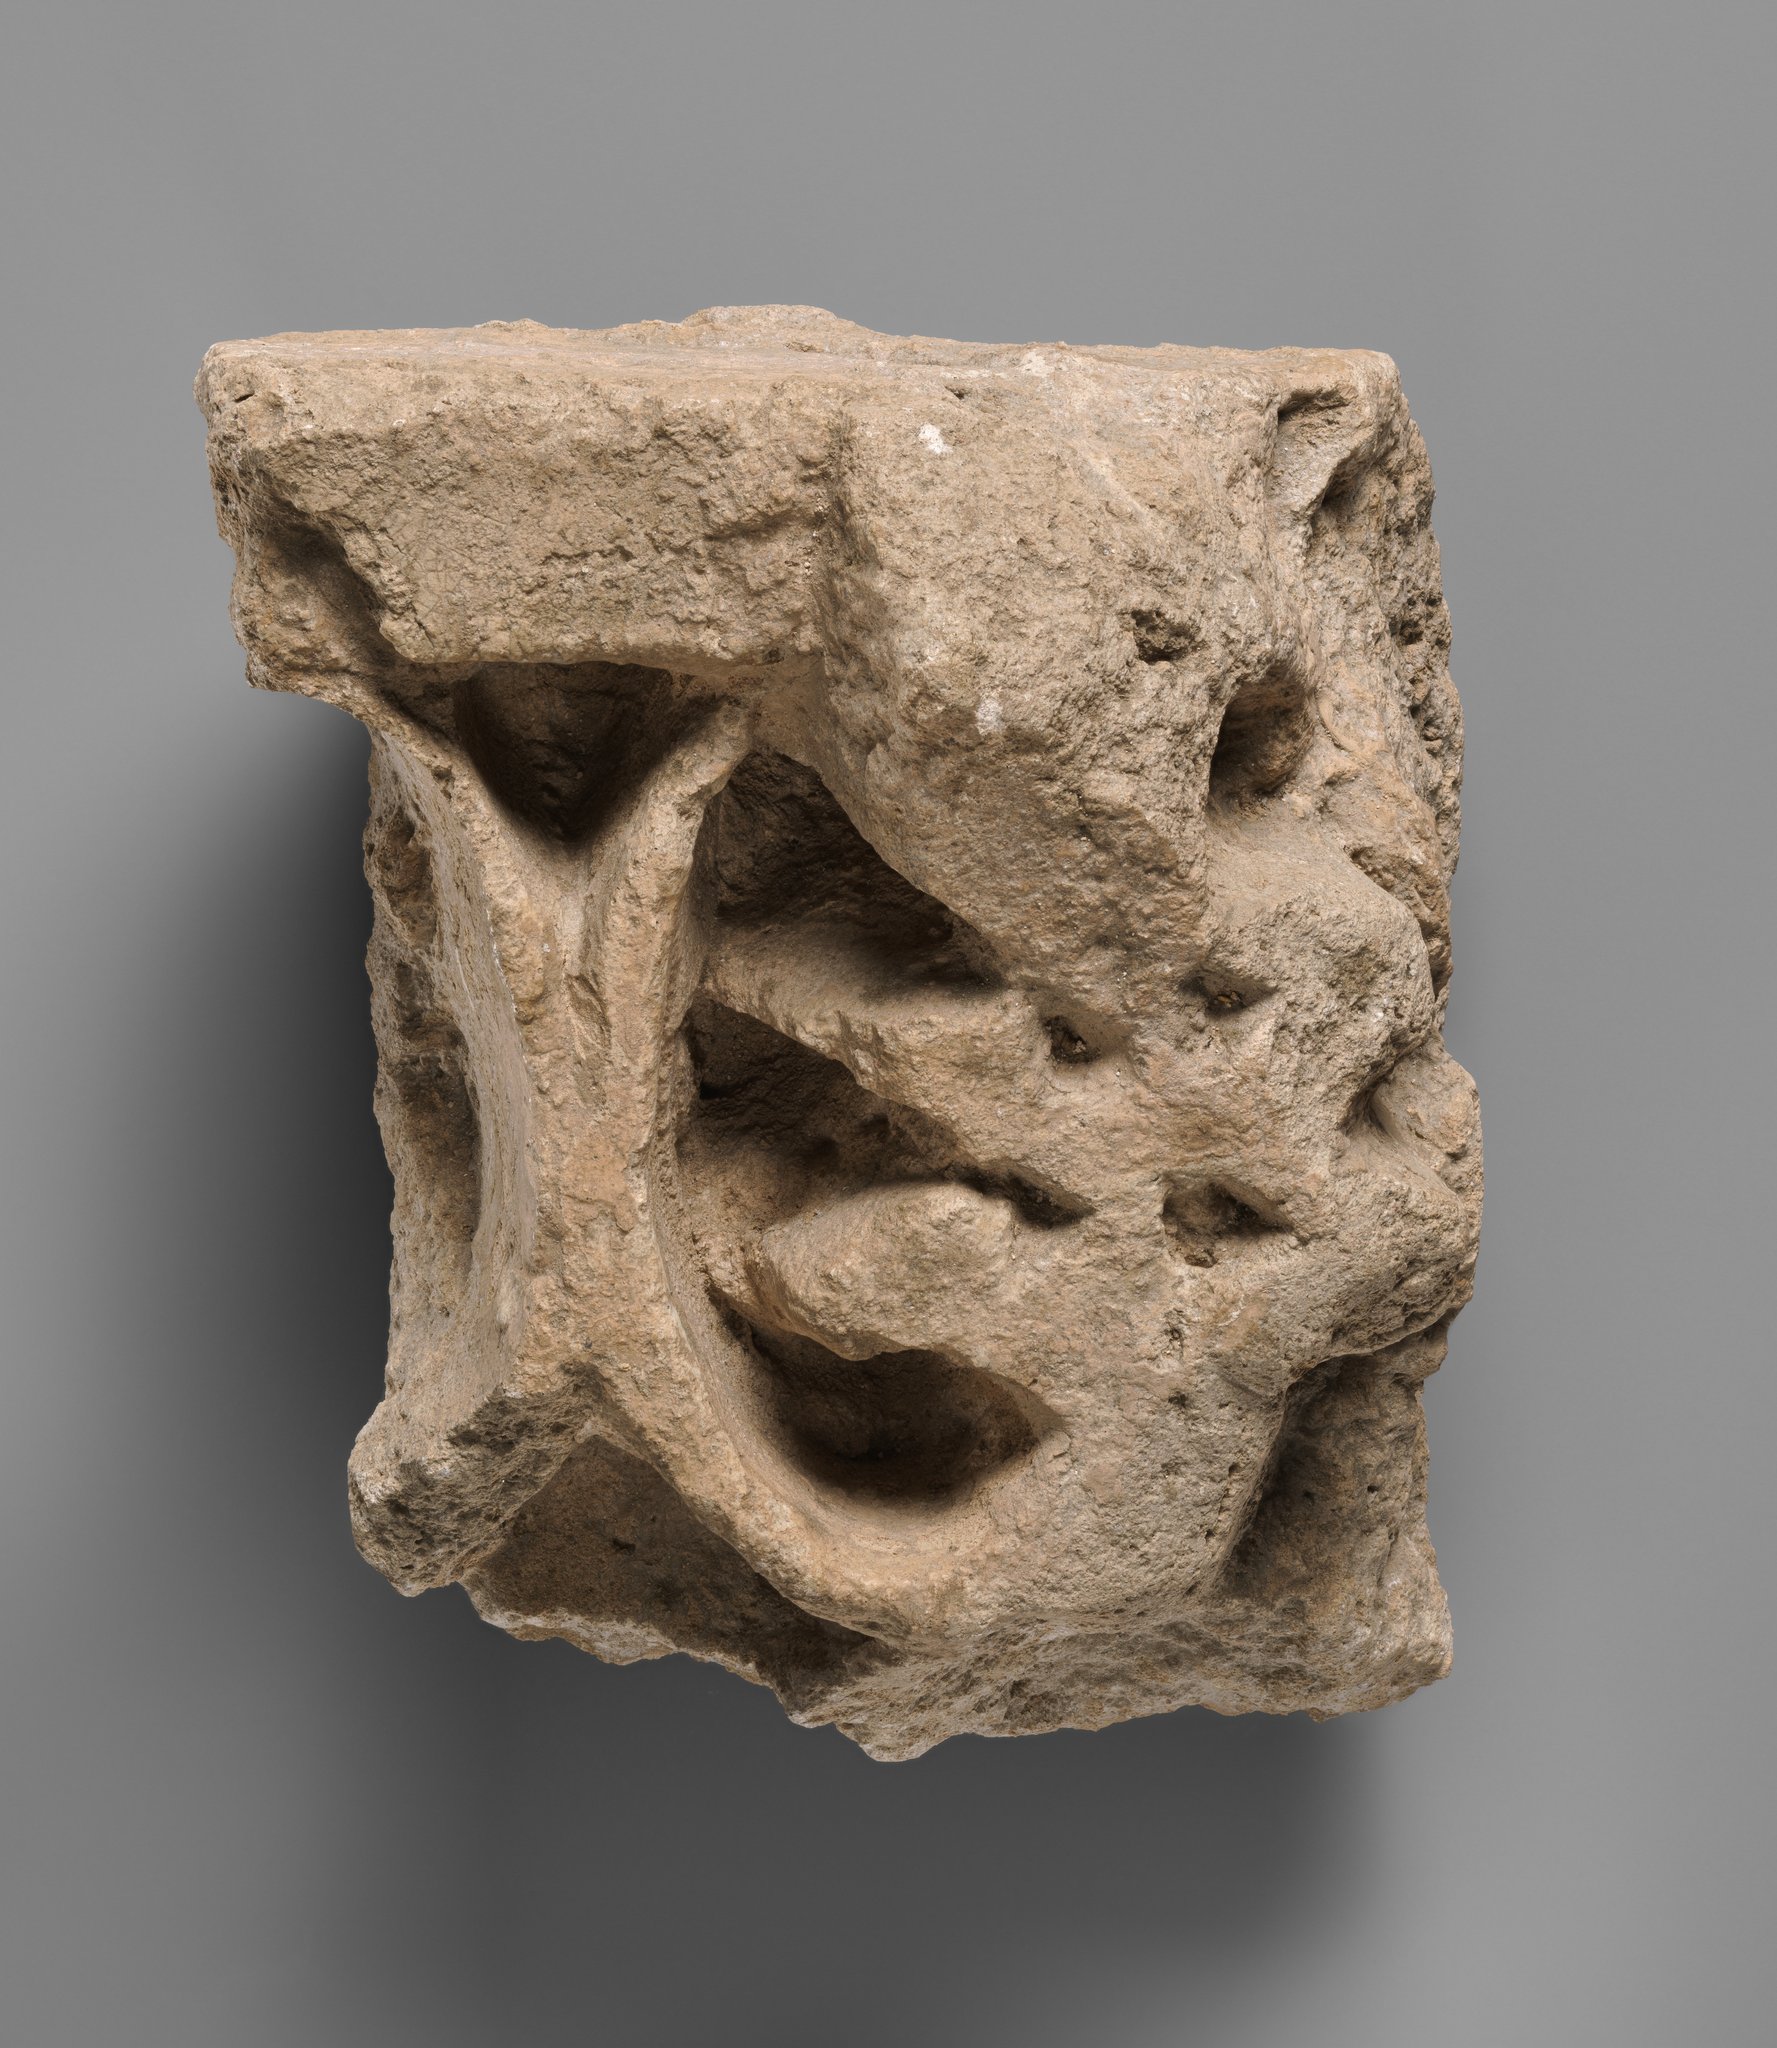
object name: relief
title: Relief fragment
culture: sasanian or islamic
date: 601-800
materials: plaster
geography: mesopotamia